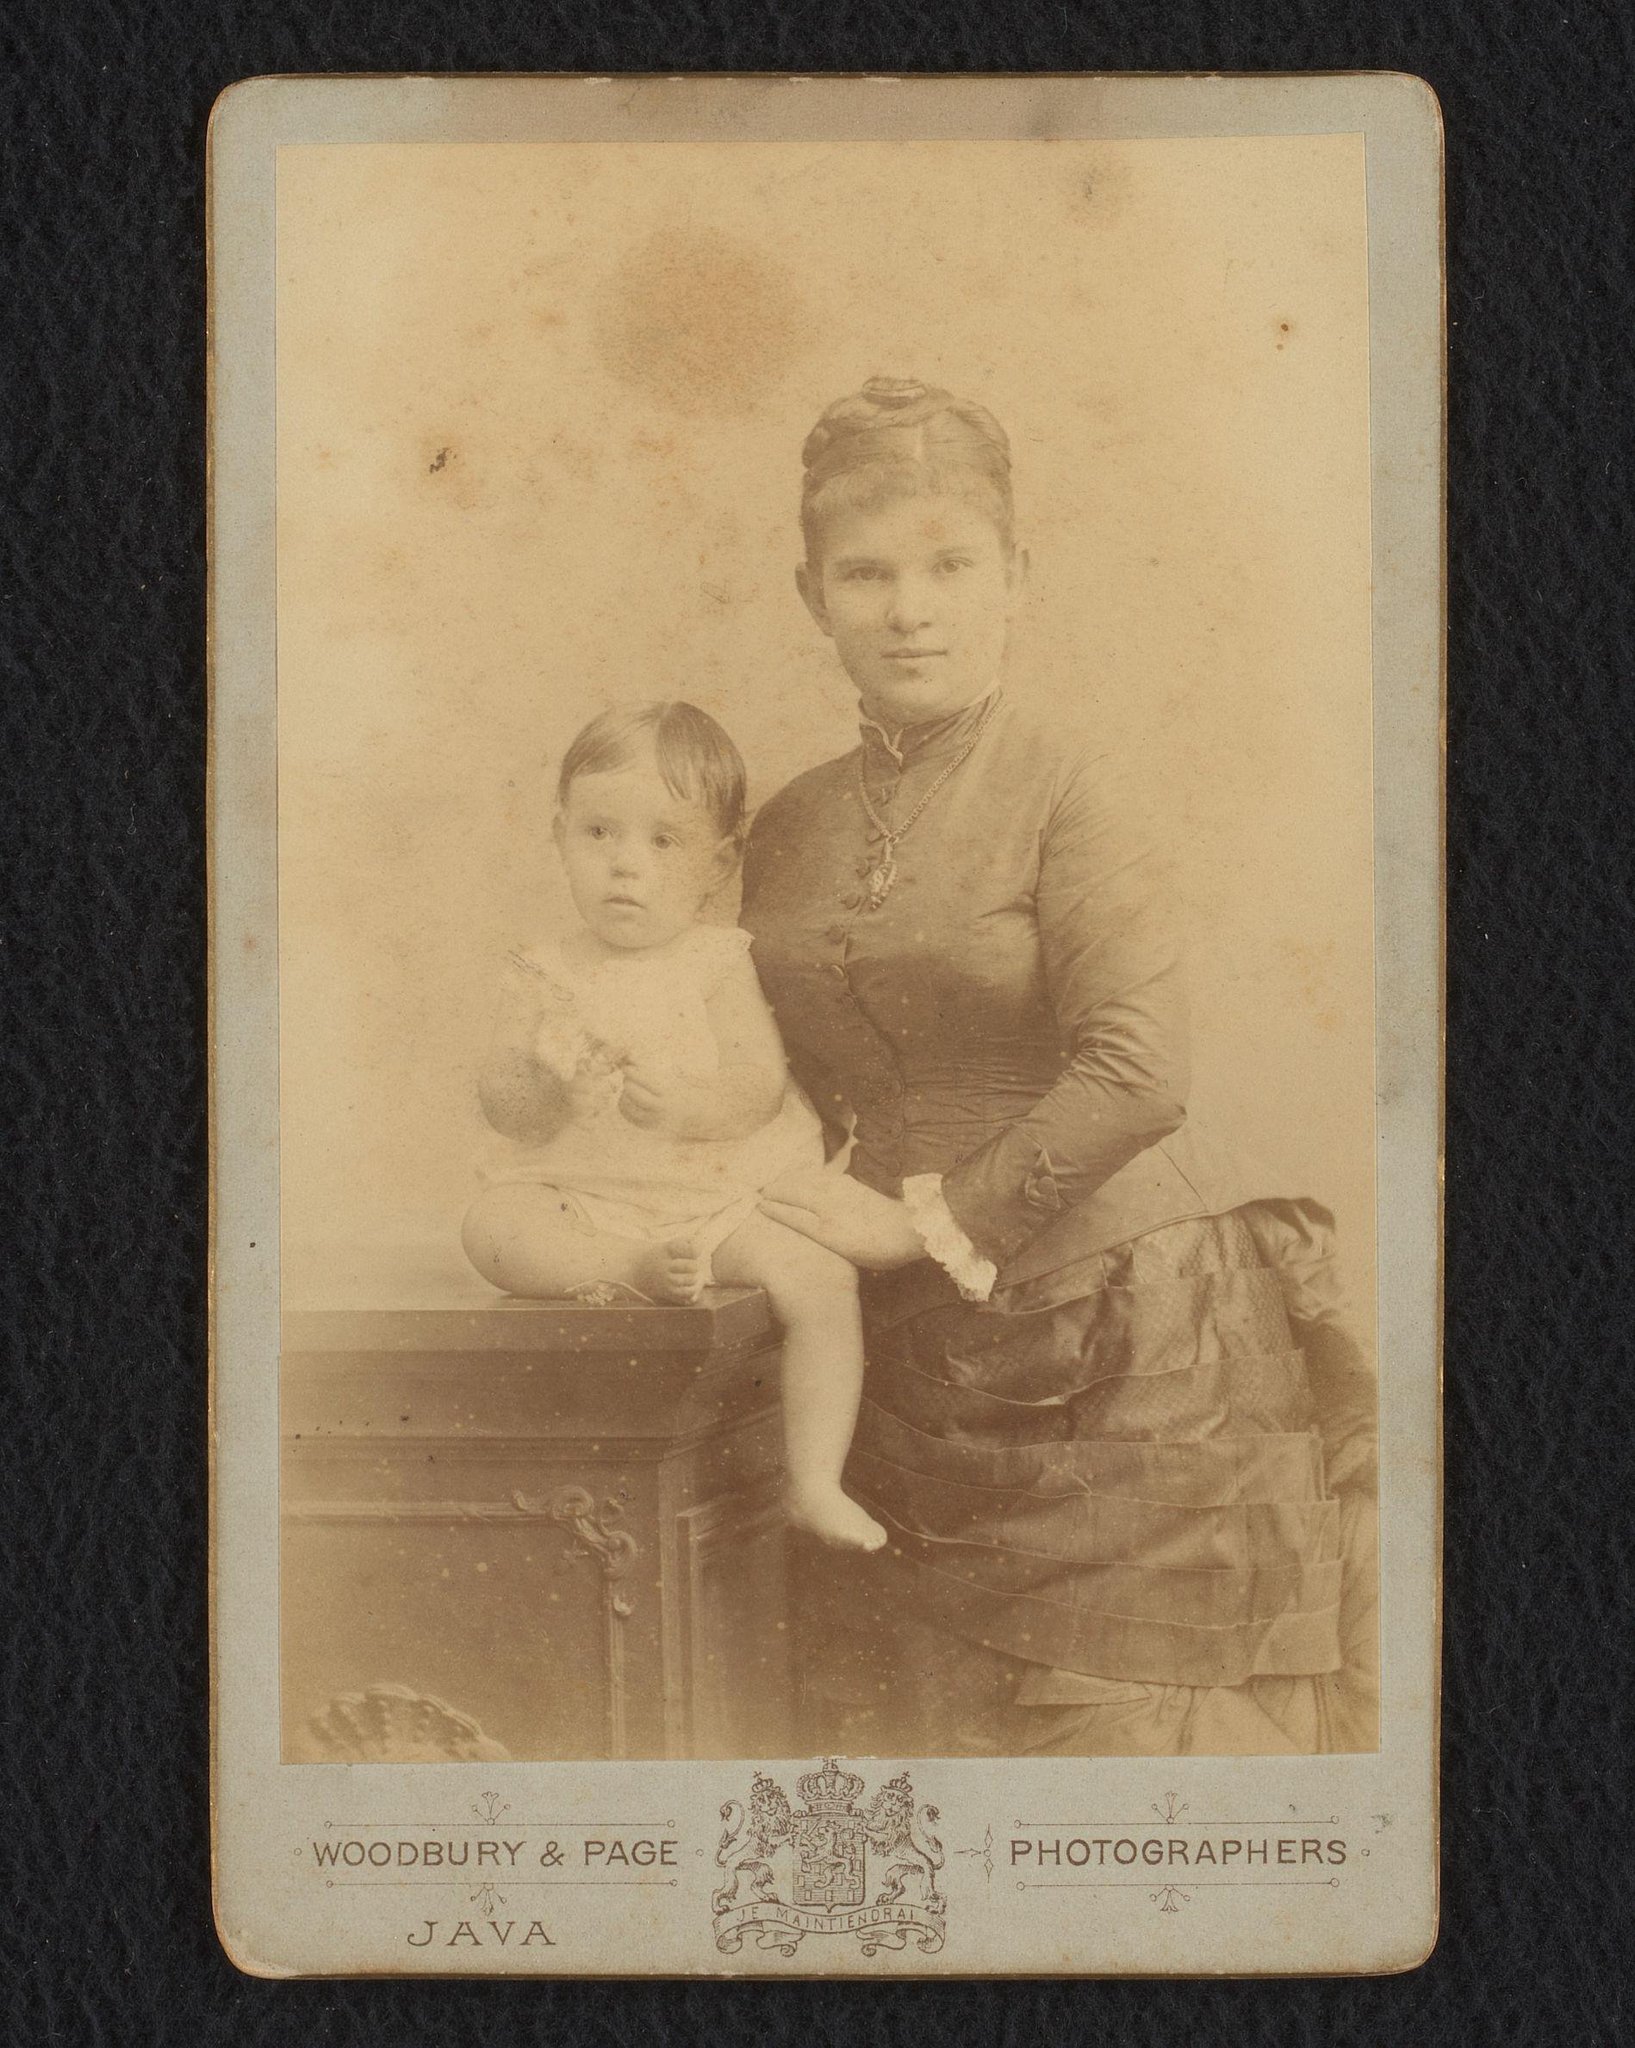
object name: cabinet photograph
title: Portret van Margo Kessler-de Lange, met An of Dolph Kessler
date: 1882-1884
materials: cardboard, paper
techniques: albumen print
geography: batavia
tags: geldolph adriaan kessler (dolph), margaretha jacoba johanna kessler-de lange (margo), historical persons, mother and baby or young child